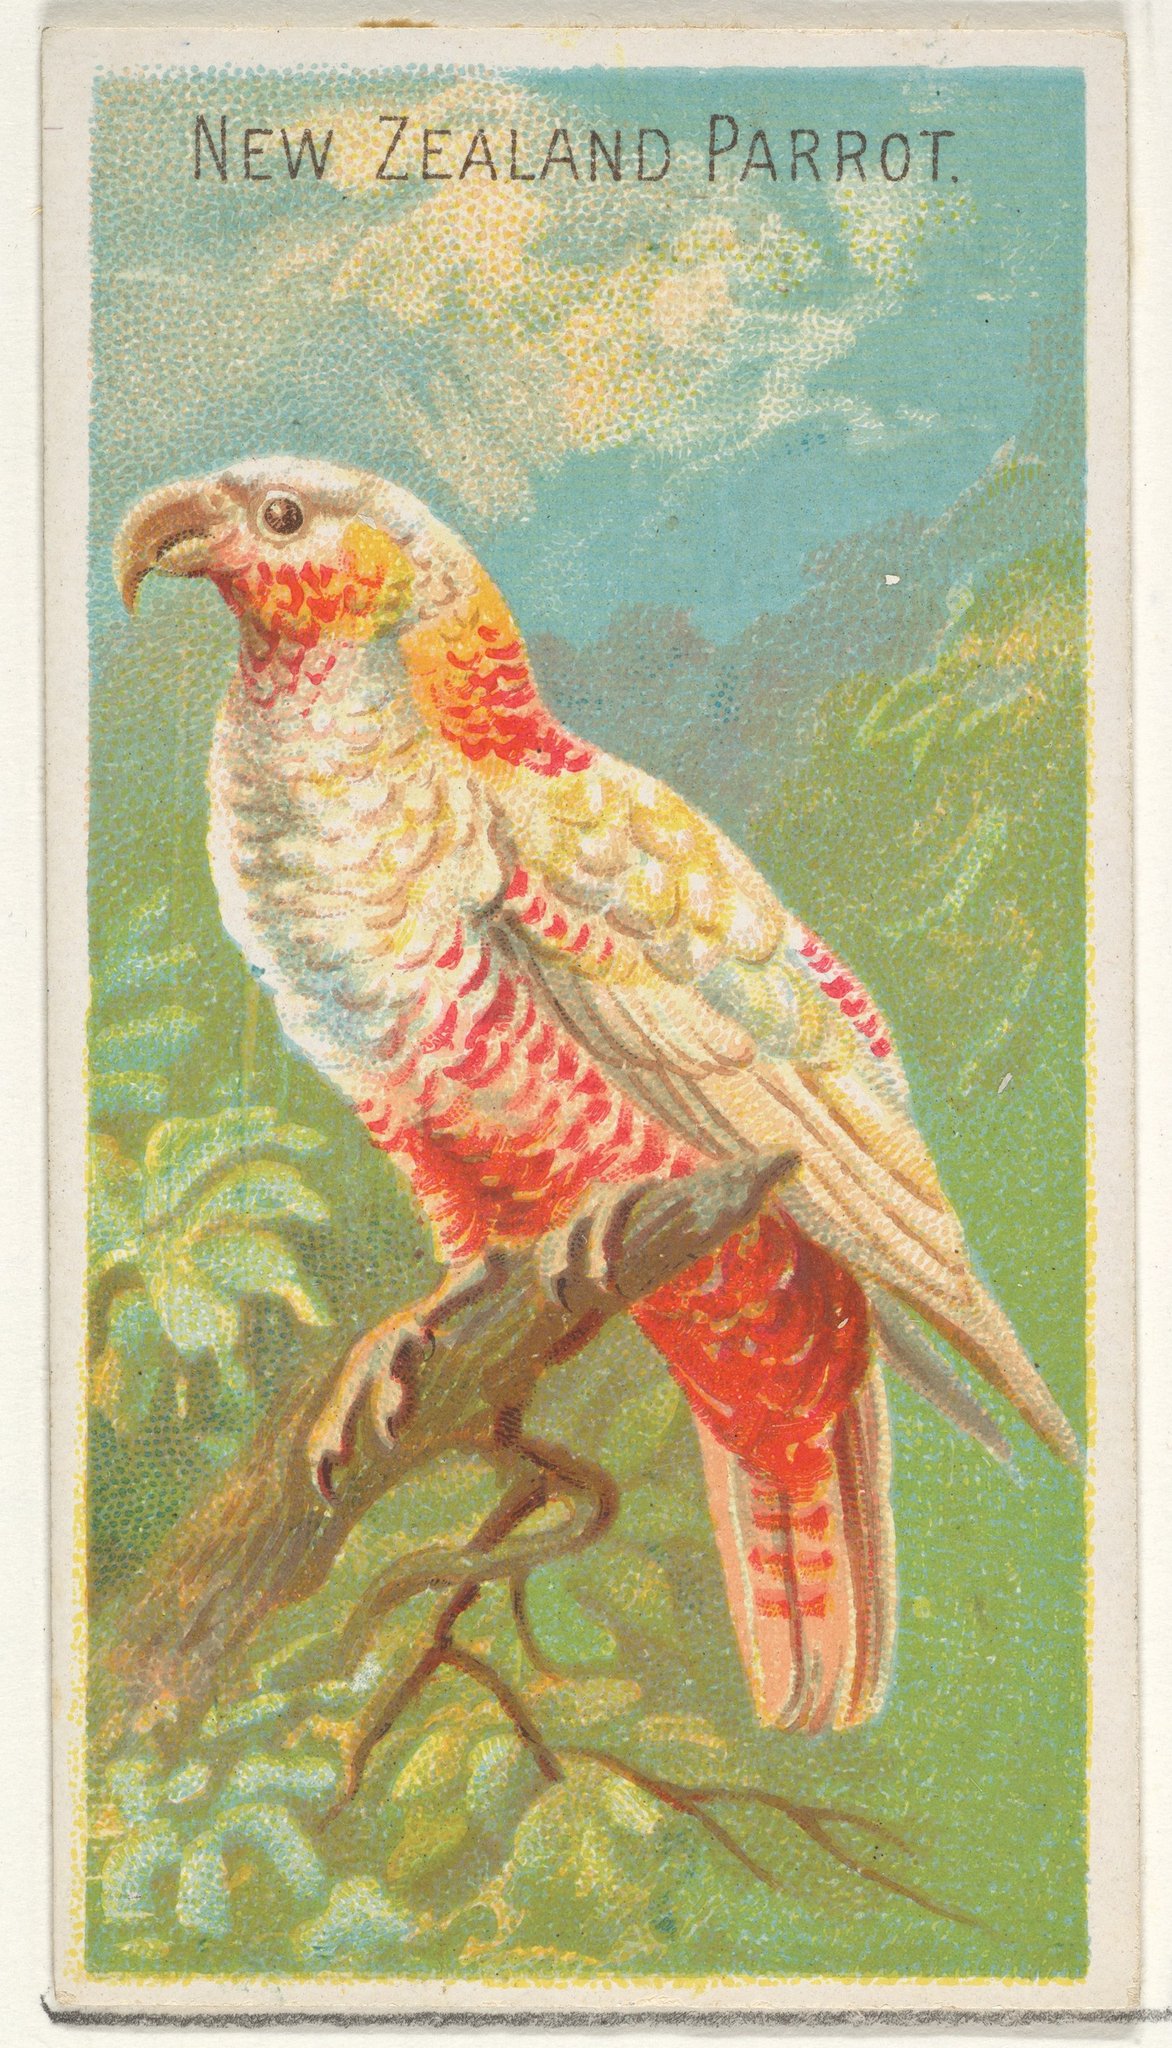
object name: print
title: New Zealand Parrot, from the Birds of the Tropics series (N5) for Allen & Ginter Cigarettes Brands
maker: allen & ginter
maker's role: publisher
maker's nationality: american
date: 1889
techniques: color lithograph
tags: parrots